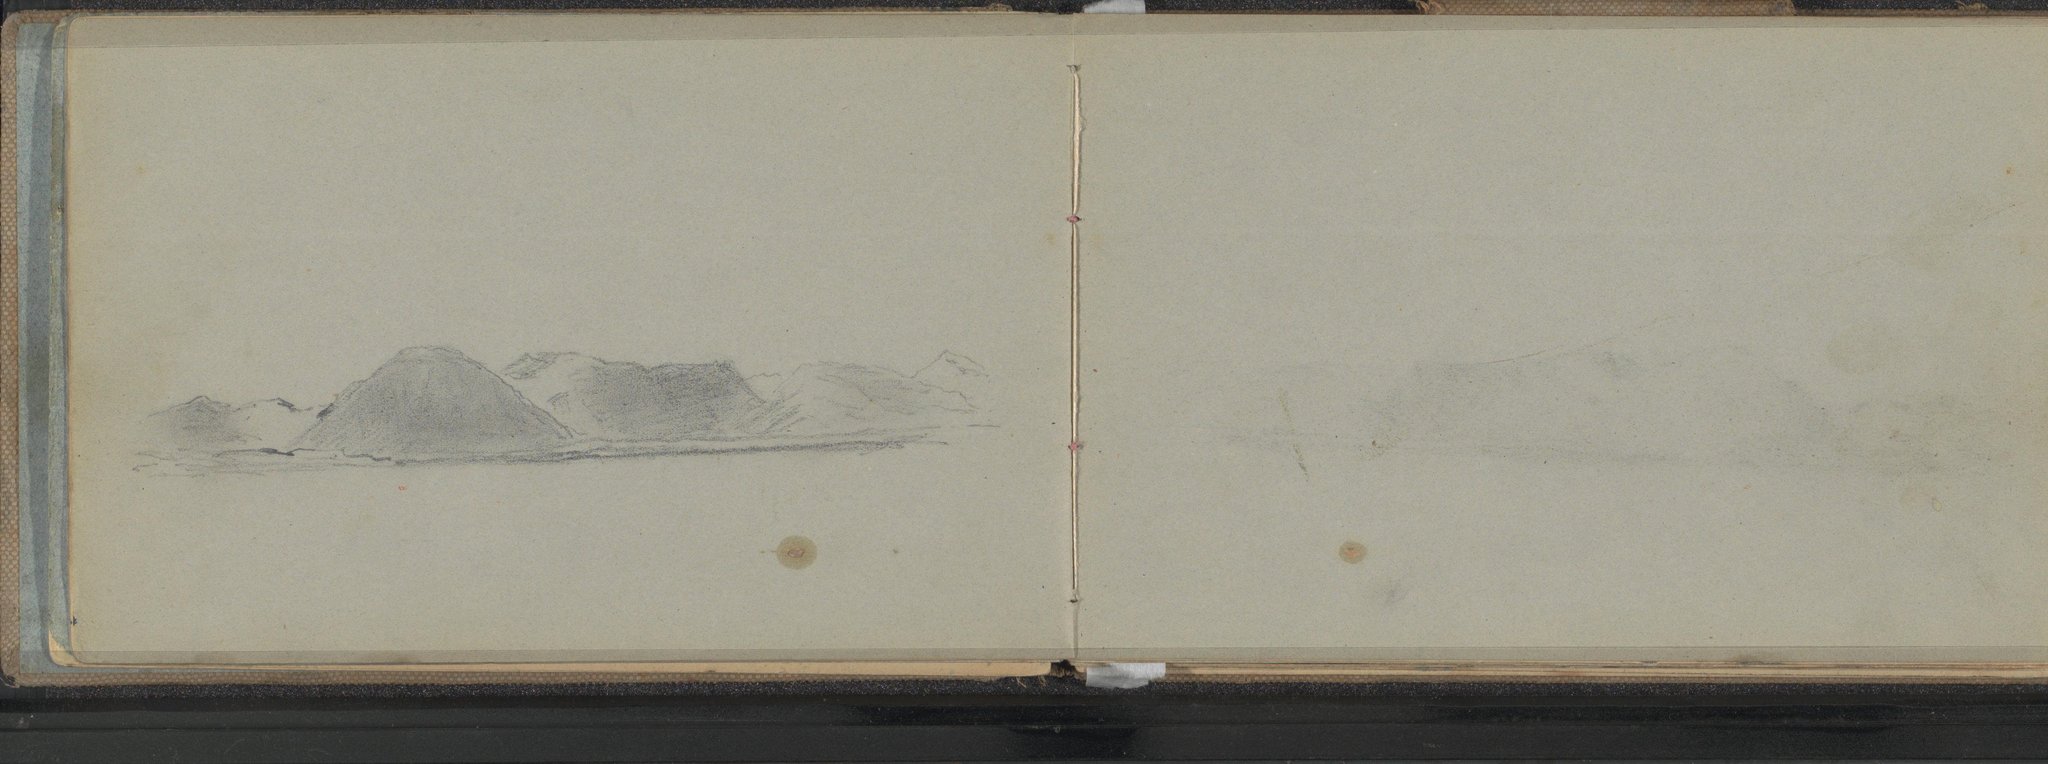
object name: sketchbook leaf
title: Kustgezicht, mogelijk Nova Zembla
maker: louis apol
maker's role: draughtsman, painter, print maker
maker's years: 1850-1936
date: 1880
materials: paper, pencil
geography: novaya zemlya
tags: coast (in polar regions)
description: Blad 10 verso uit een schetsboek met 35 bladen betekend tijdens de expeditie naar Nova Zembla in 1880.